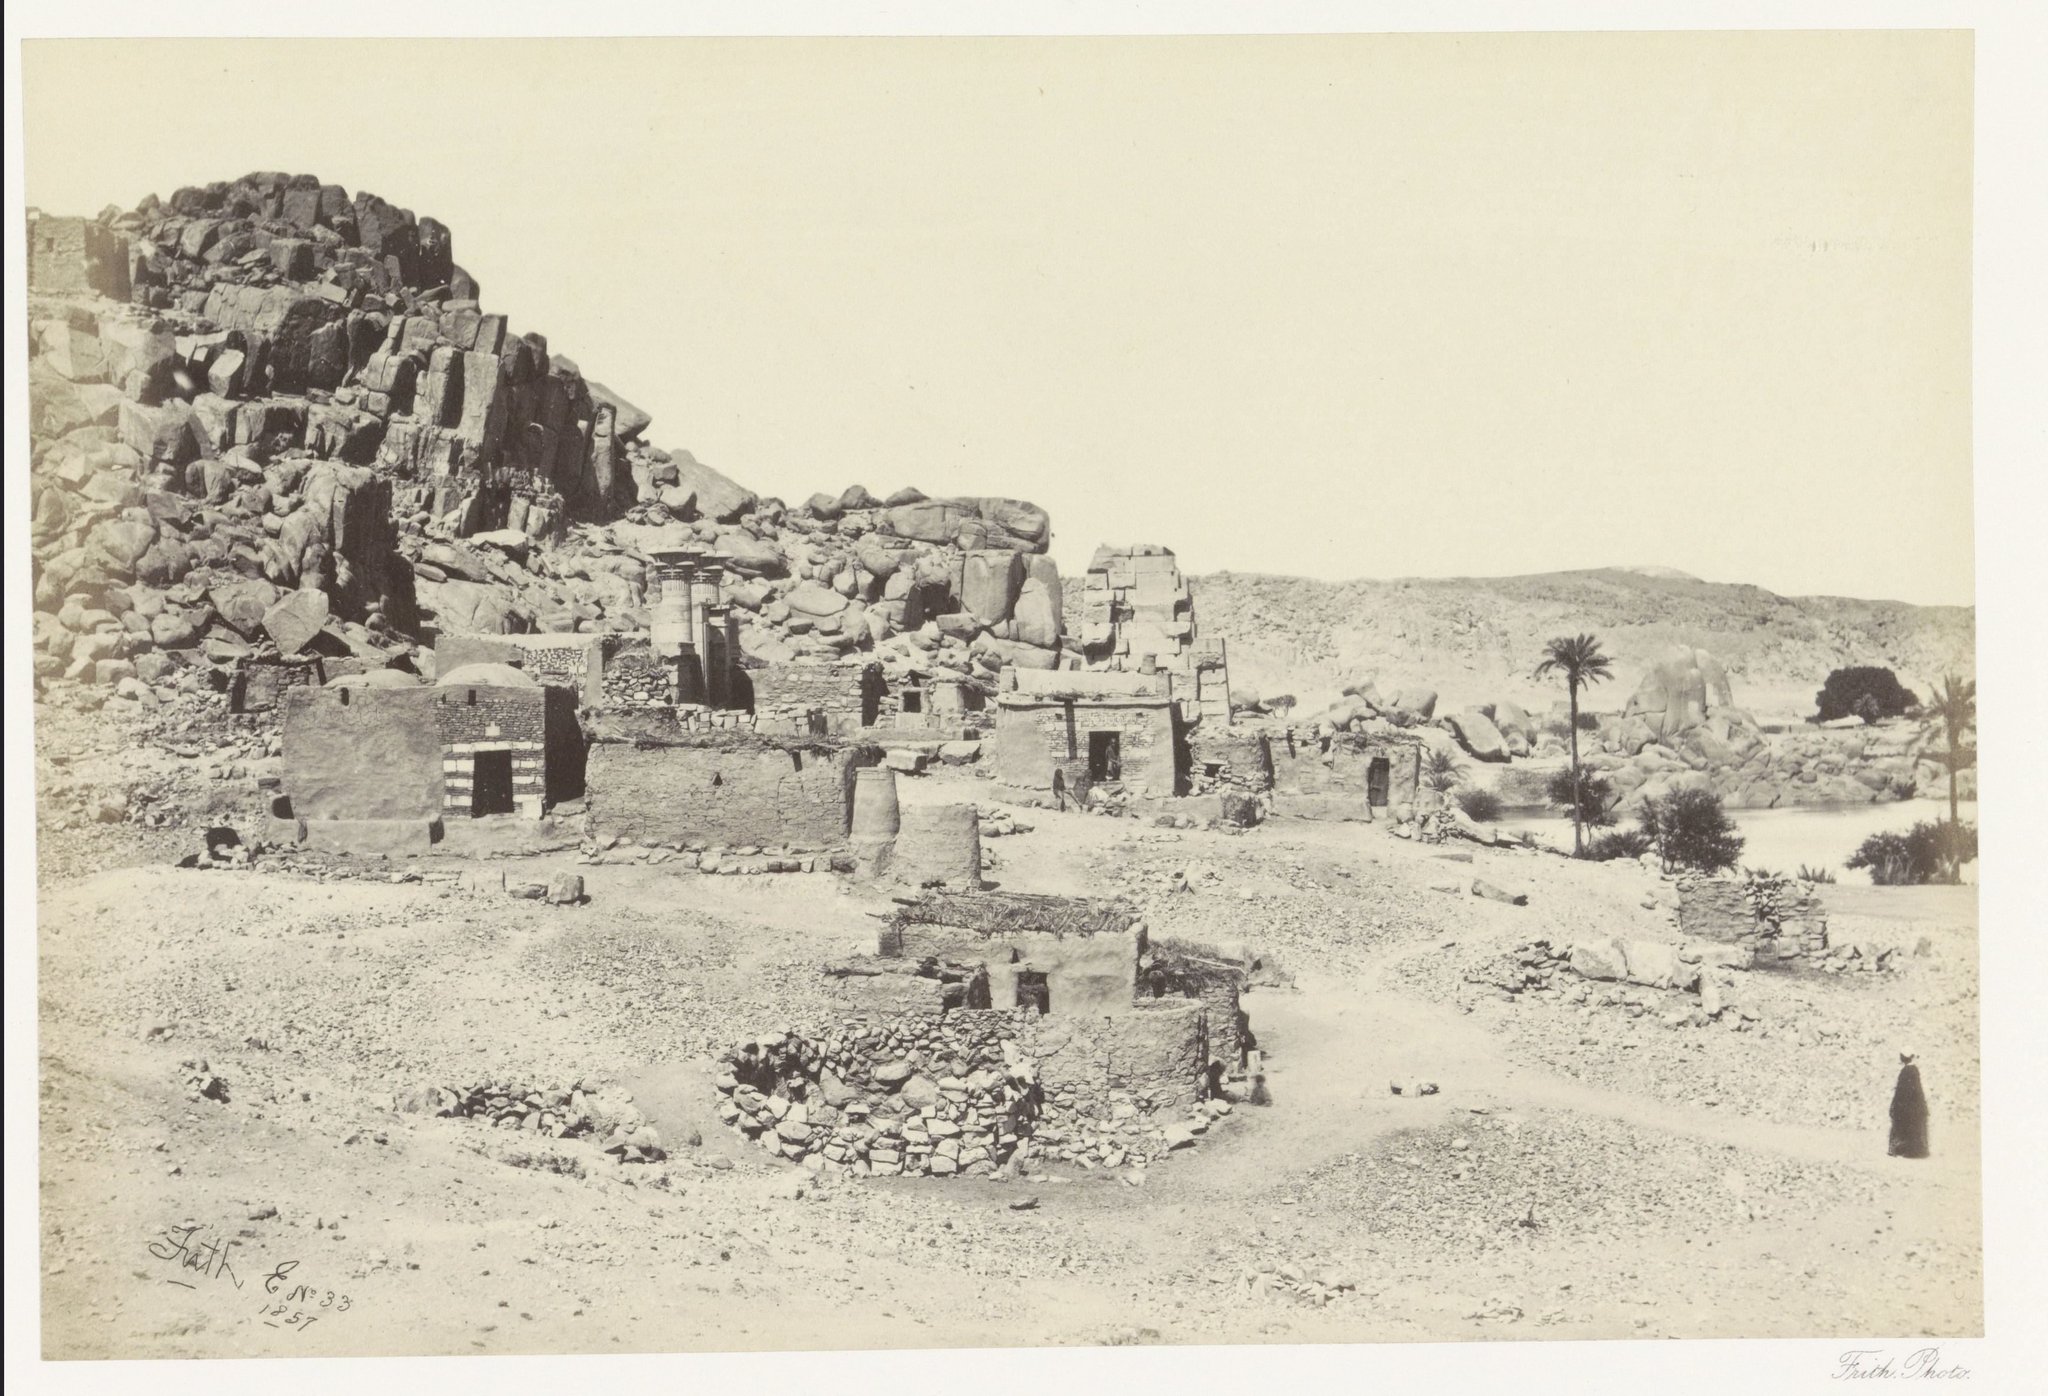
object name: page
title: Ruïnes op het eiland Bigeh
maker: francis frith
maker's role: publisher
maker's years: 1822-1898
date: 1857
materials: paper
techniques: albumen print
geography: bigeh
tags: landscape with ruins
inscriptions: number: ‘E No 33’